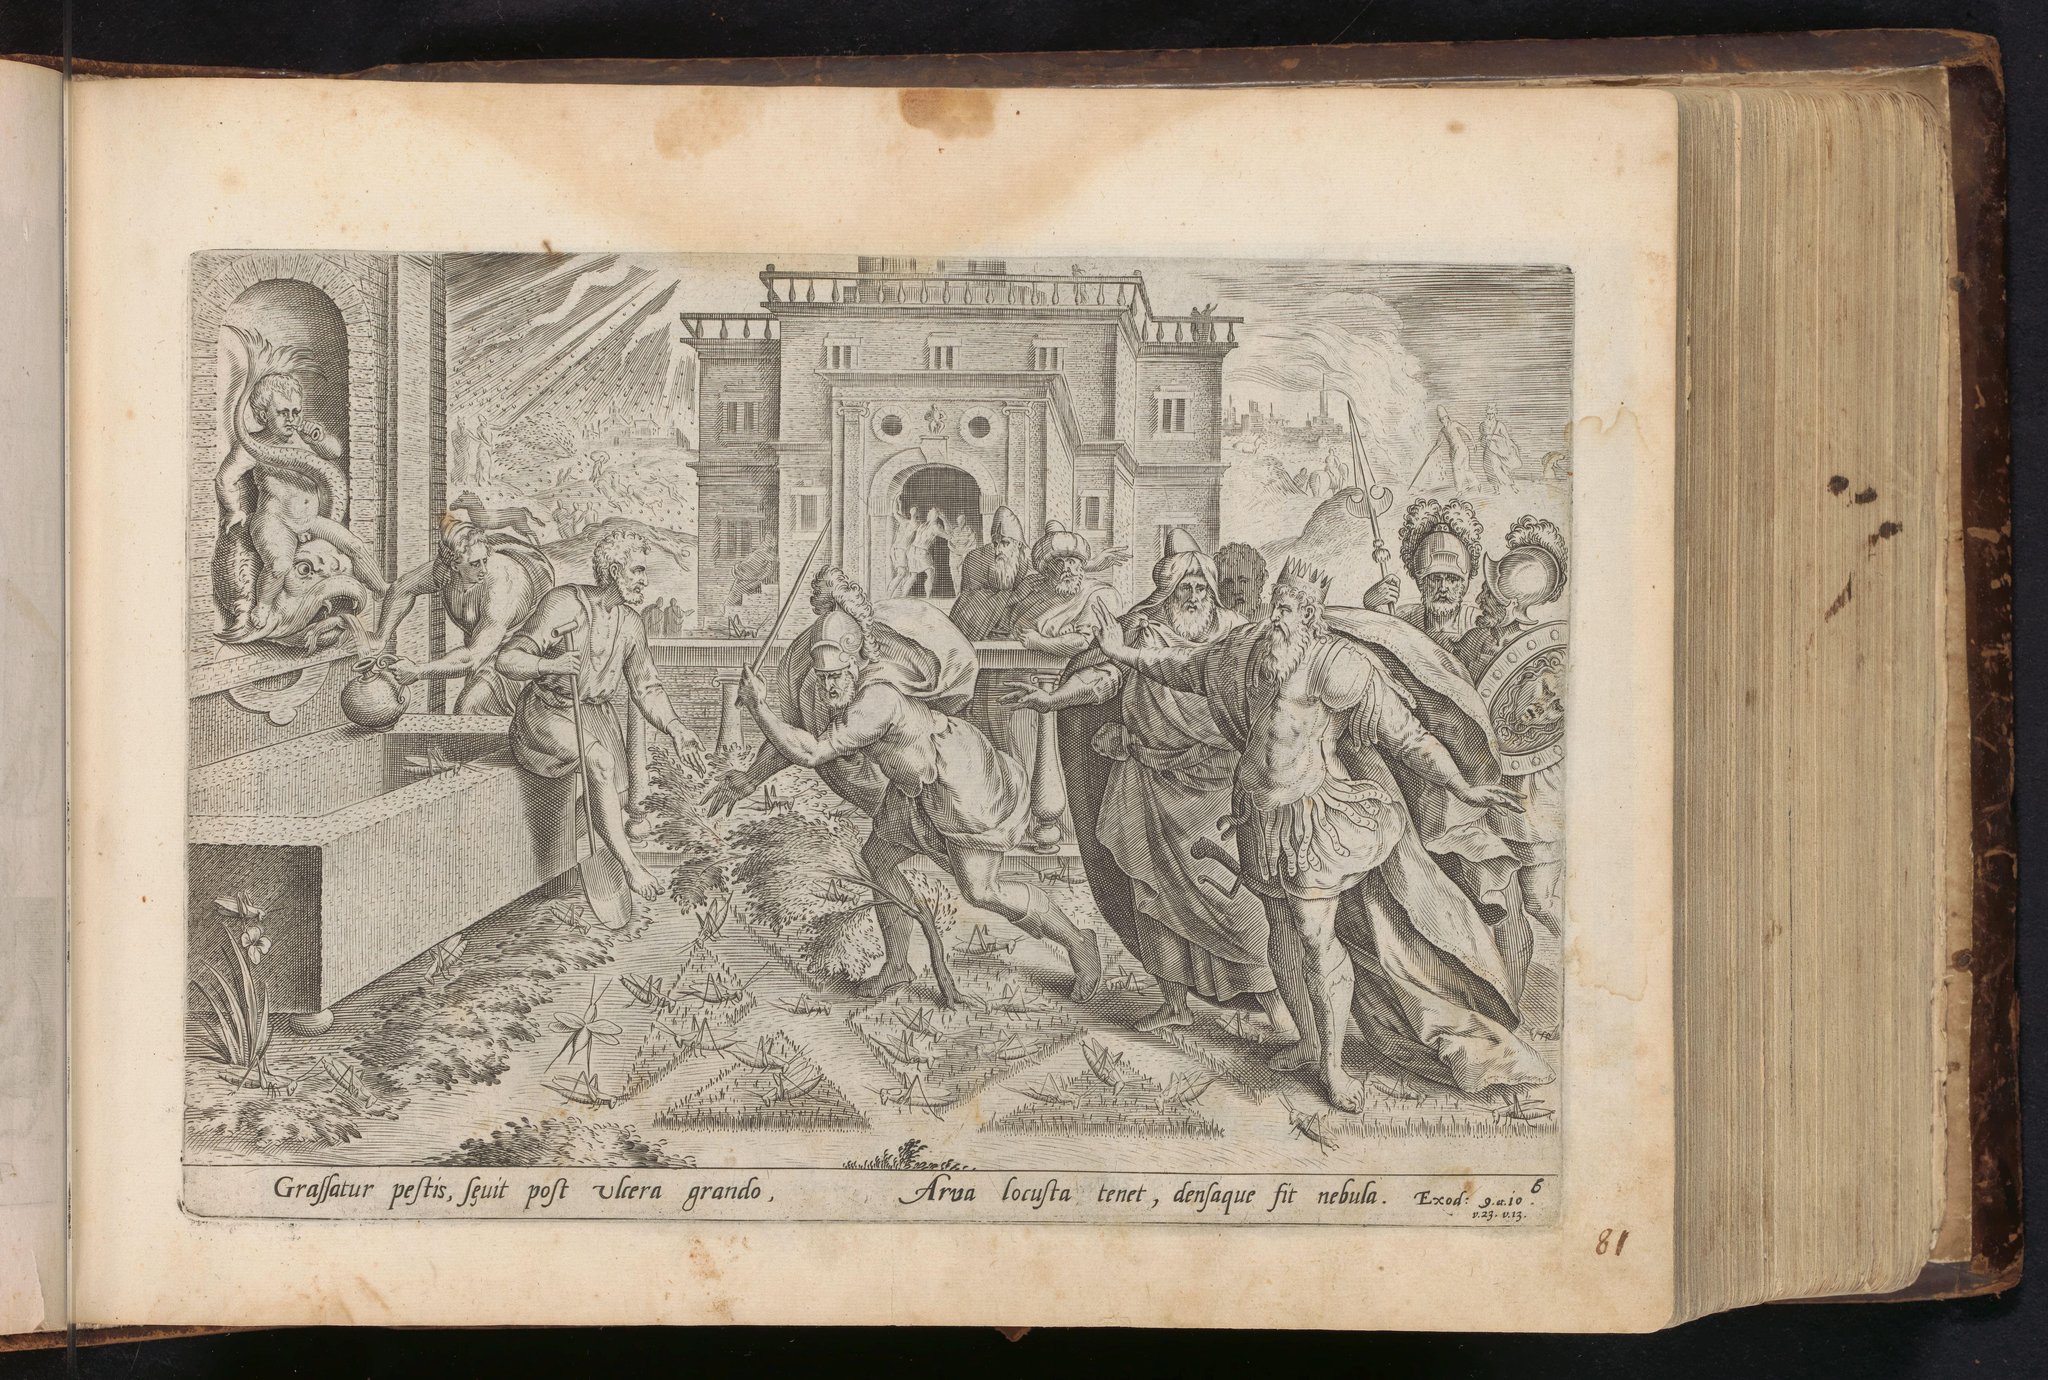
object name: album leaf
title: Plagen van de sprinkhanen en de hagel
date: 1579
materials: paper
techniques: engraving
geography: alkmaar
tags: the plague of hail: moses raises his rod towards the sky, and hail and fire fall to the ground, the plague of locusts: as moses raises his hands the locusts come and eat everything that has survived the hail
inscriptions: number: ‘81’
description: Op de voorgrond de achtste plaag die God over Egypte liet komen: een sprinkhanenplaag. De farao beveelt een van zijn soldaten de sprinkhanen dood te slaan. Links vult een dienaar een kruik met water. Op de achtergrond links de zevende plaag van Egypte: hagelstenen. Op de achtergrond links en rechts Aäron en Mozes die de plagen oproepen. Onder de voorstelling een verwijzing in het Latijn naar de Bijbeltekst in Ex. 9:23 en 10:13. Deze prent maakt deel uit van een album.